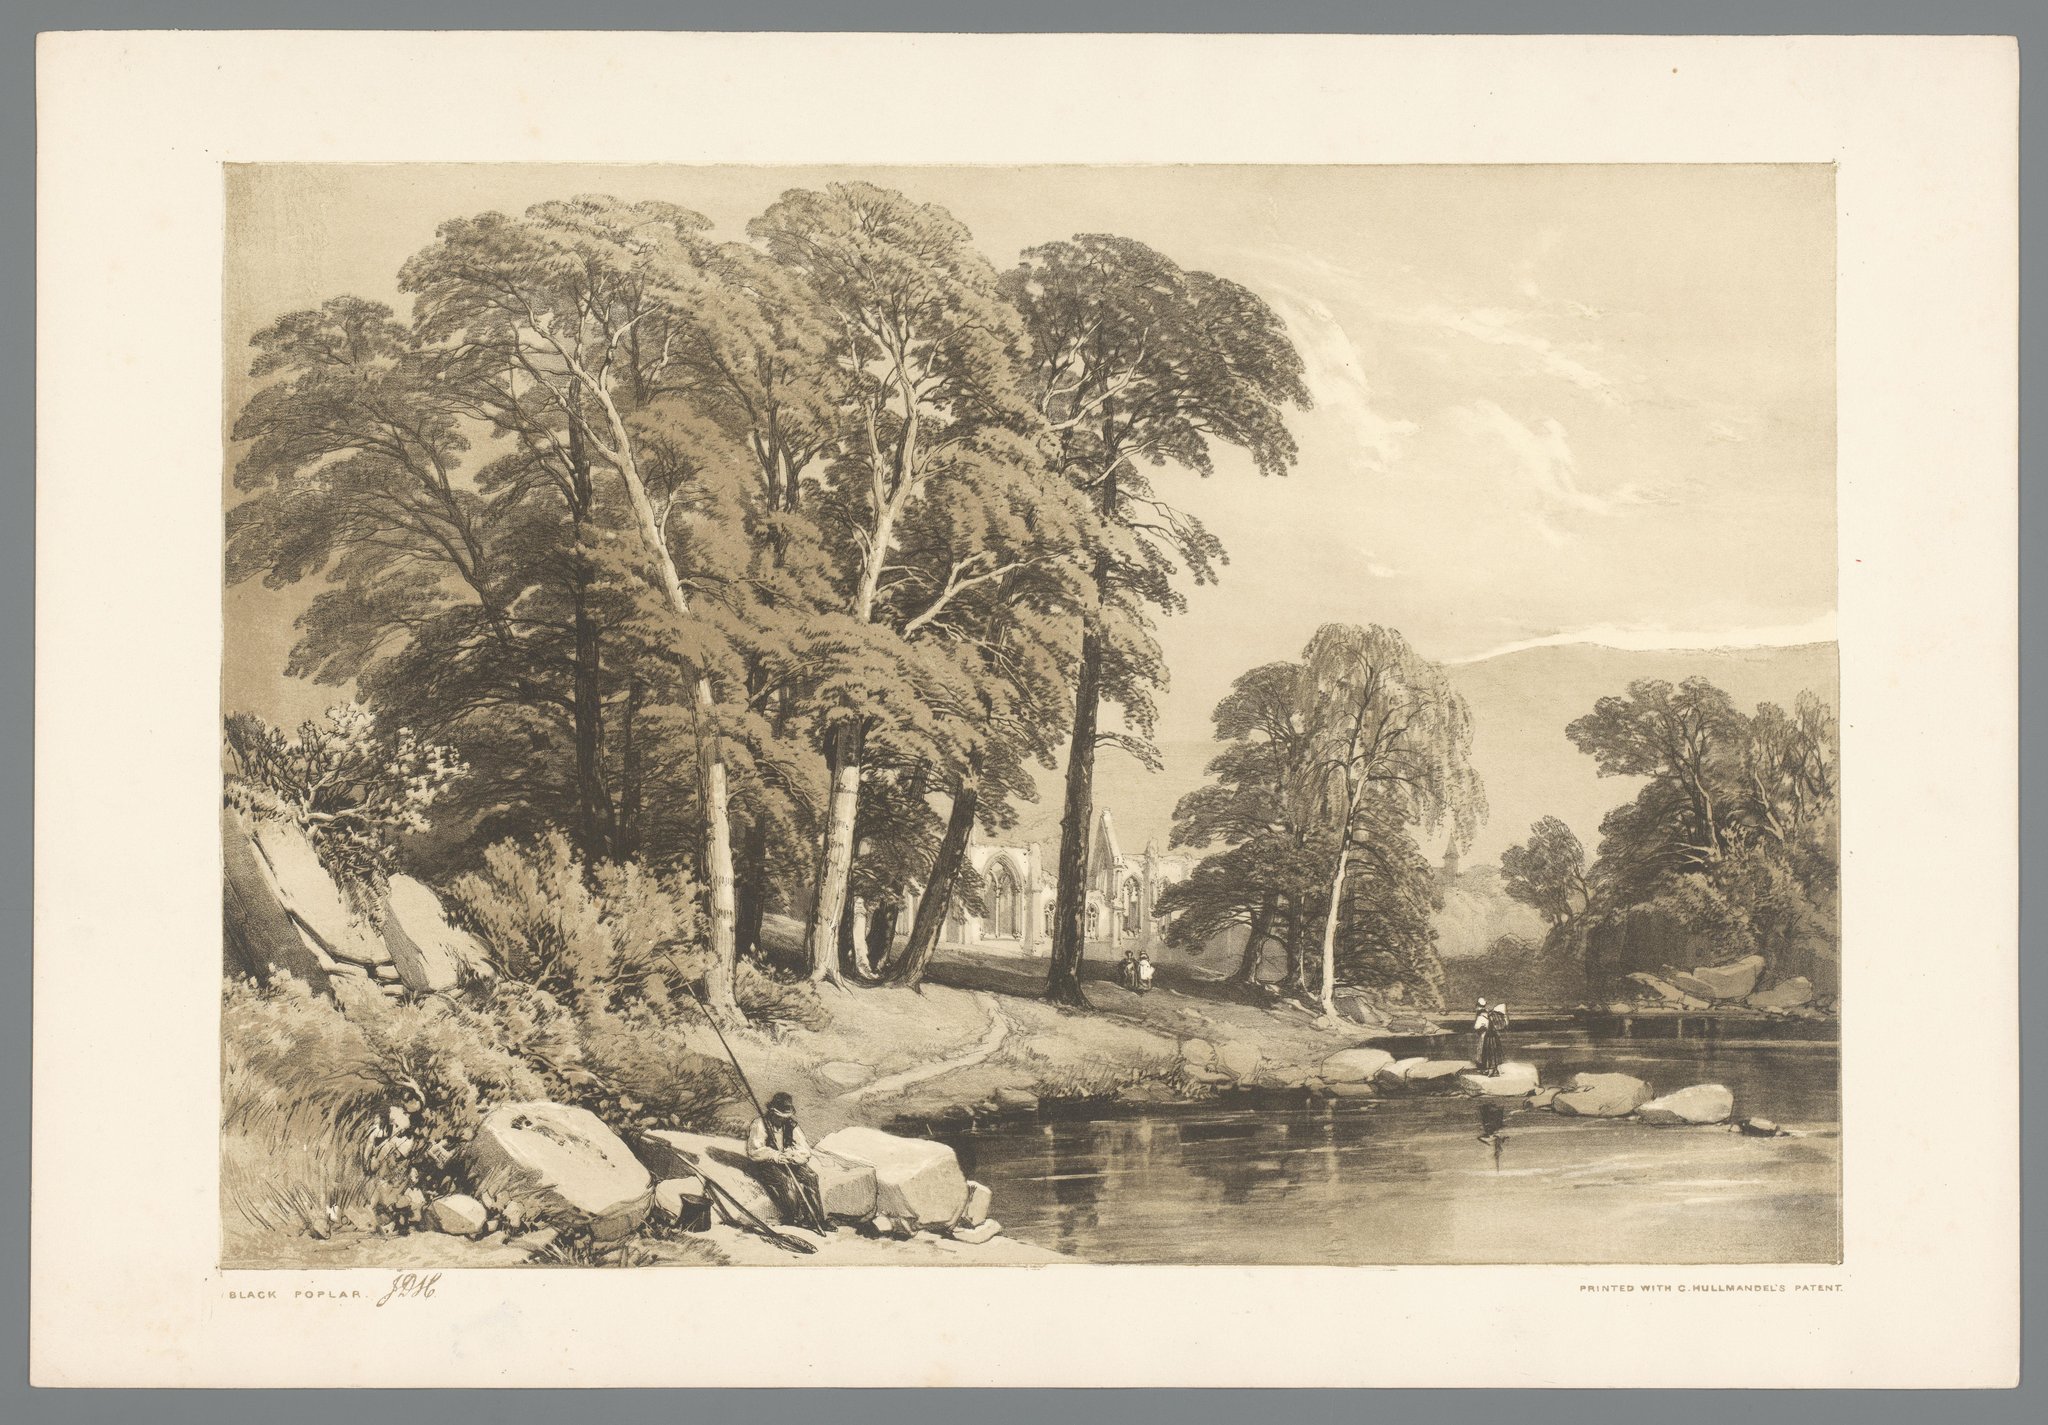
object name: print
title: Gezicht op een oever bij het Bolton klooster nabij Twickenham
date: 1841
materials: paper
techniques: tone lithography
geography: london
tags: park, forest, wood, abbey wall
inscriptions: collector's mark: Lugt 2228, collector's mark: Lugt 2760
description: Prent maakt deel uit van een serie van 24 prenten.